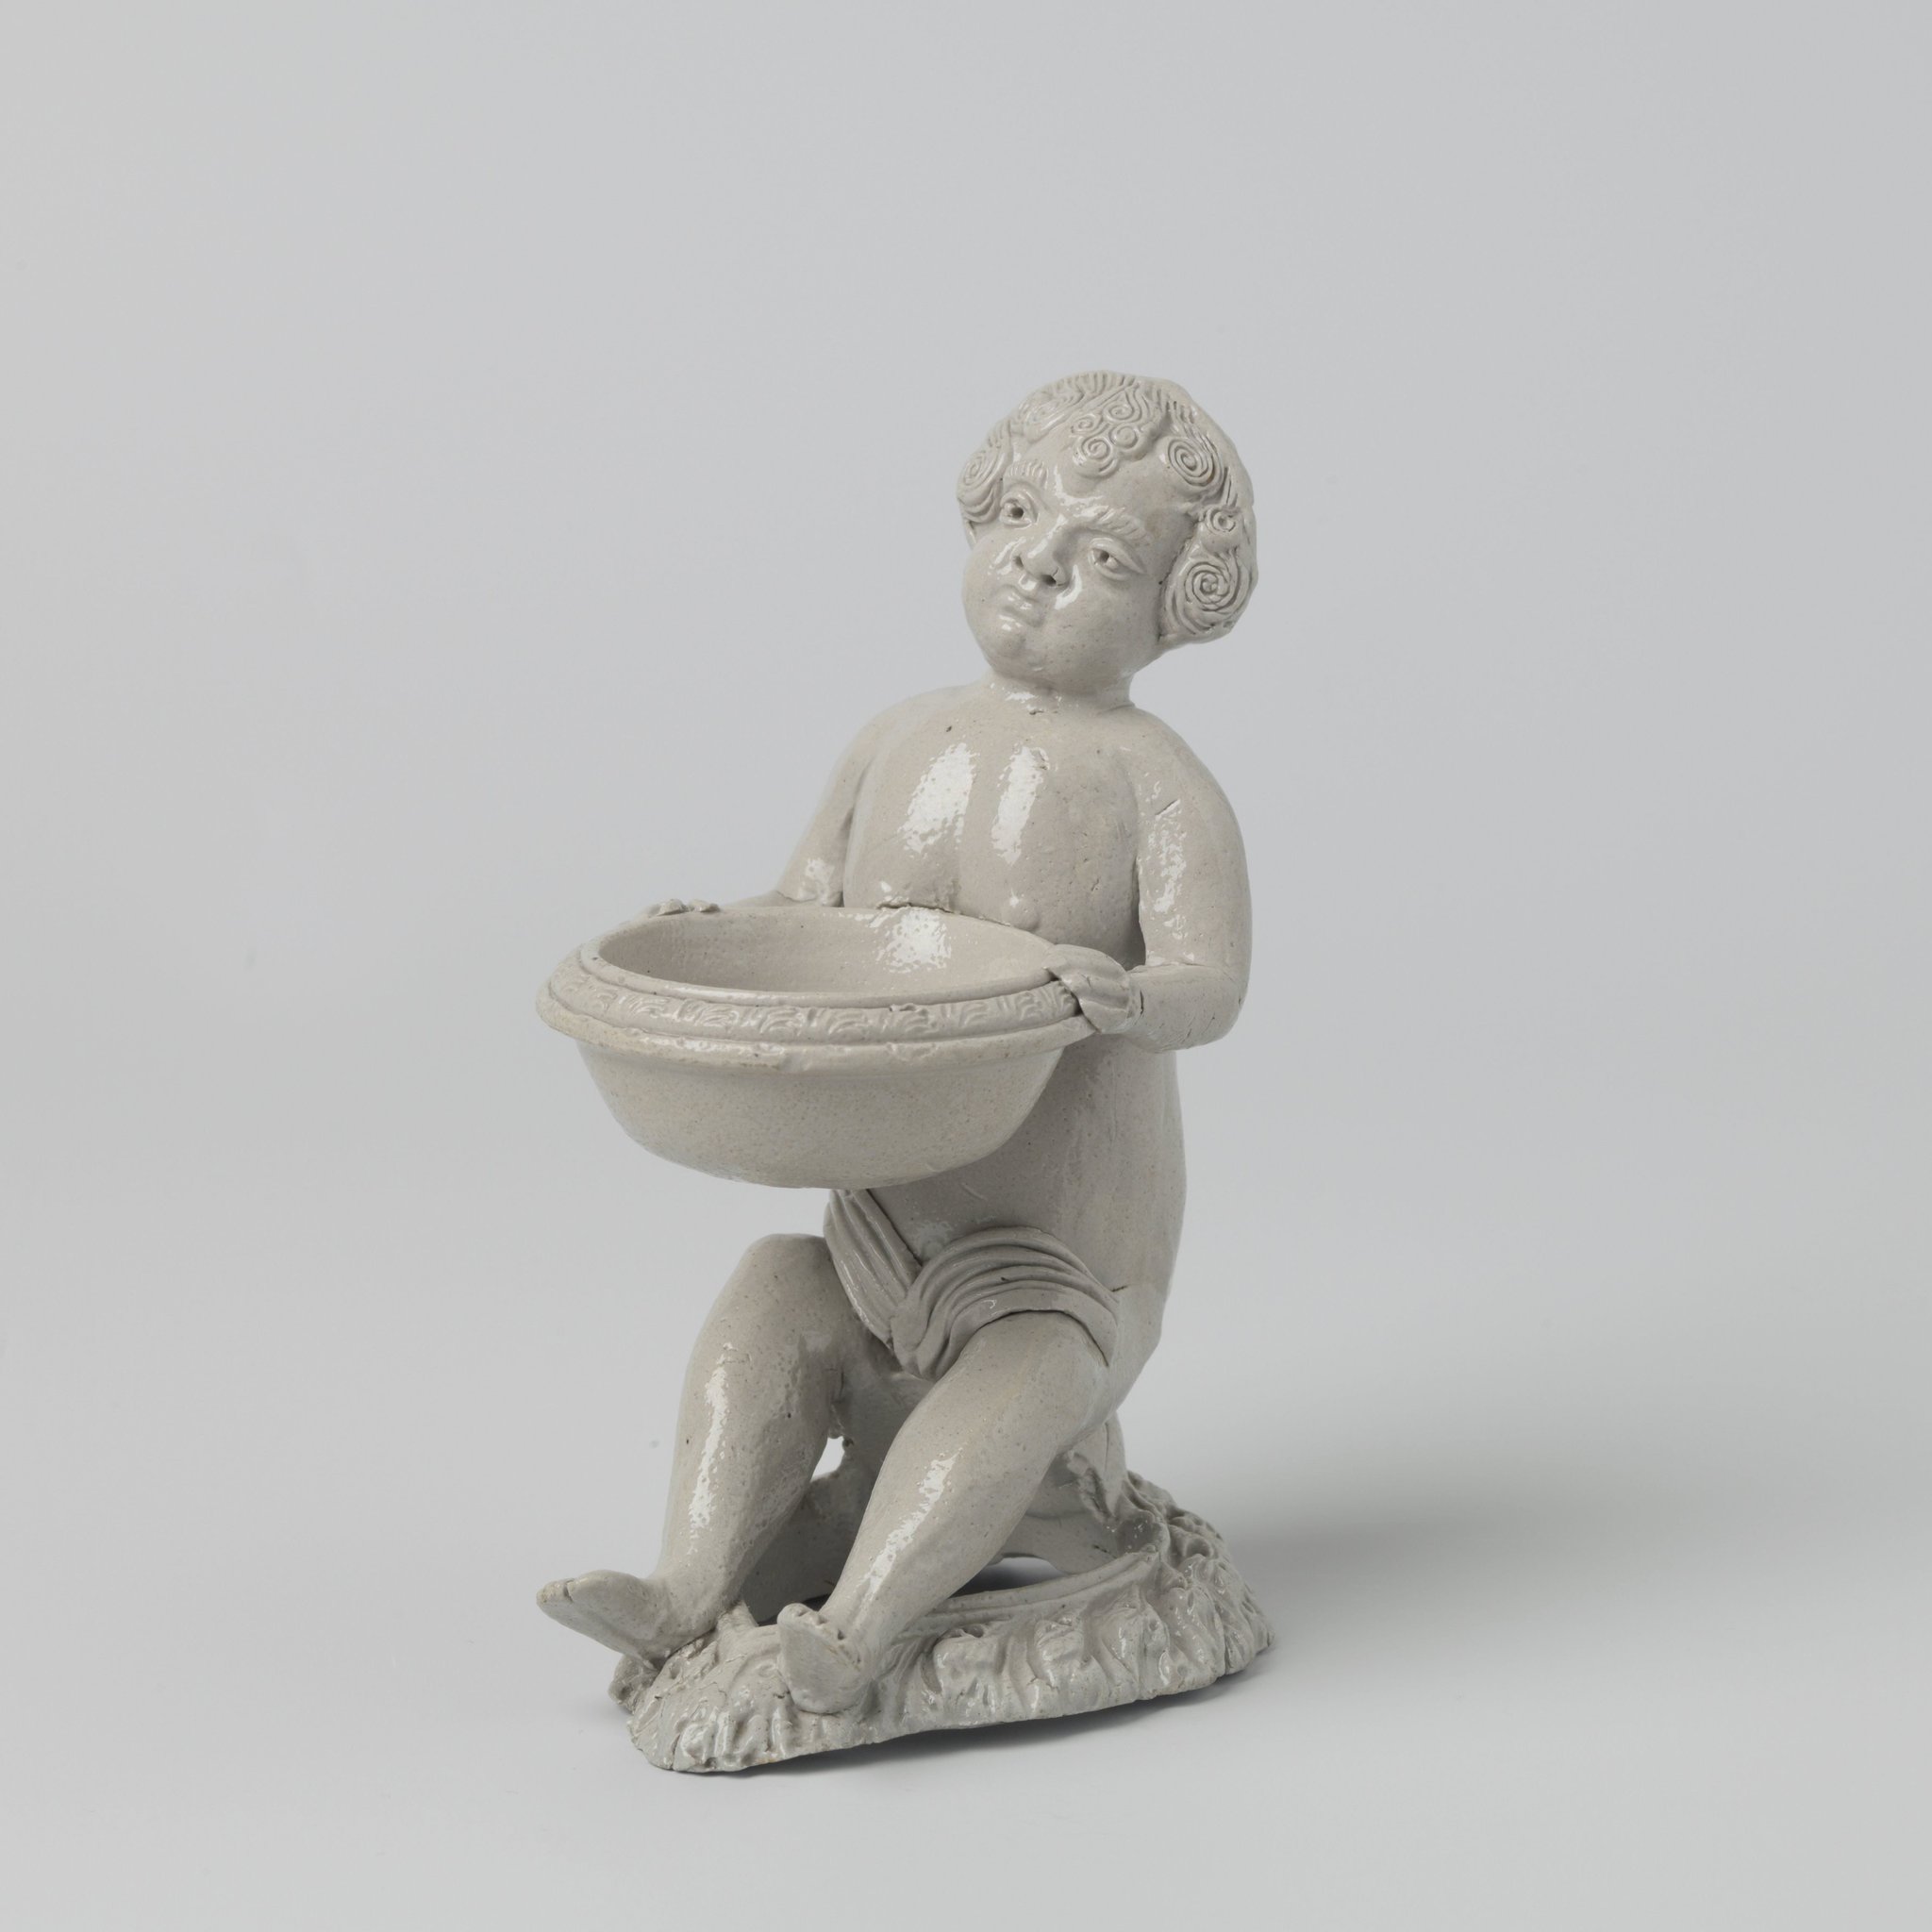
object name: salt condiment vessel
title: Salt cellar in the shape of a seated figure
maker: Anonymous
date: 1750-1780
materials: glaze, stoneware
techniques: firing, forming, relief, vitrification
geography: westerwald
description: Zoutvat van steengoed in de vorm van een naakt, zittend persoon (jongen of engel?) op een krans van gedrukte en opgelegde bladranken in reliëf. Hij houdt met twee handen de kom vast. Westerwald.